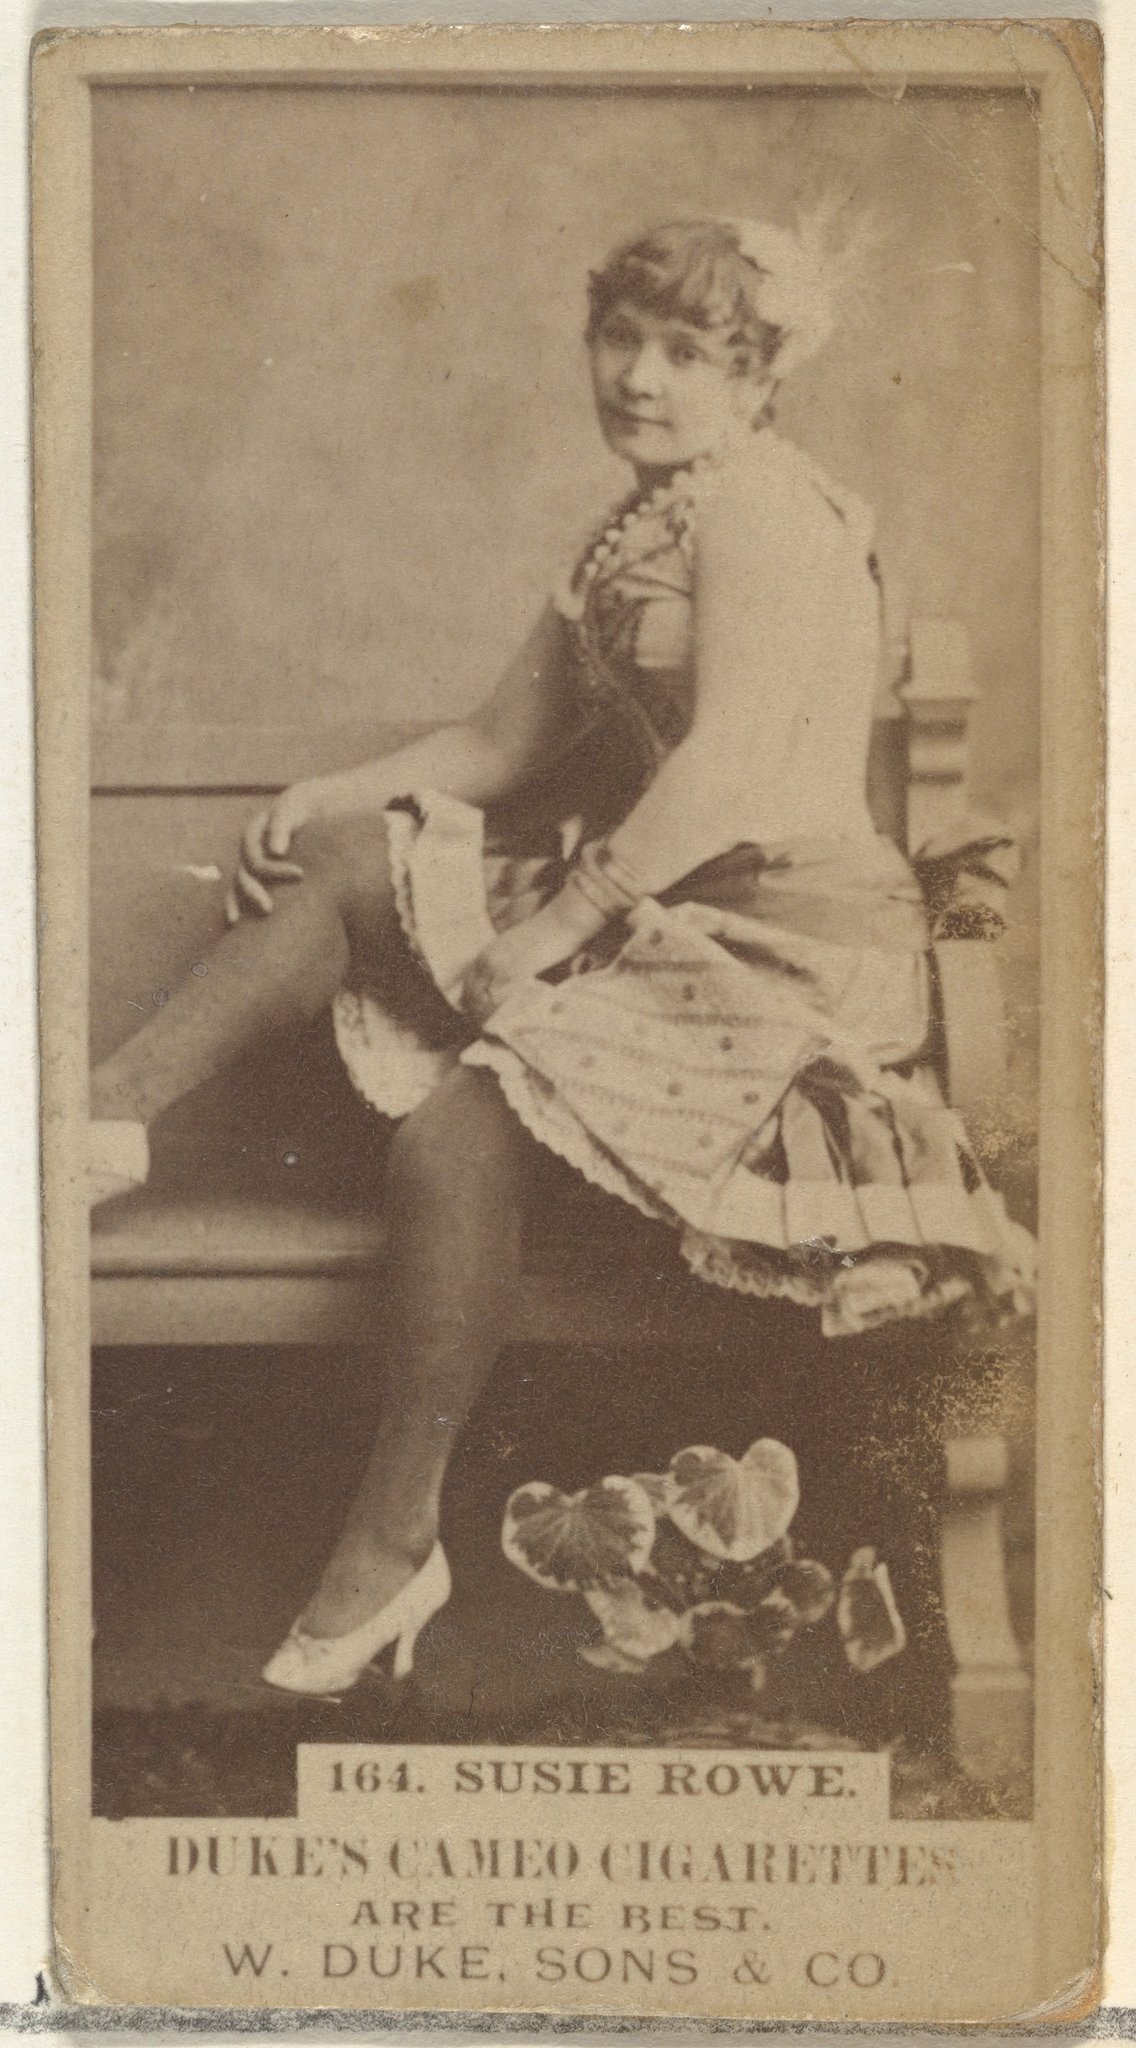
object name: photograph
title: Card Number 164, Susie Rowe, from the Actors and Actresses series (N145-5) issued by Duke Sons & Co. to promote Cameo Cigarettes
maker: w. duke, sons & co.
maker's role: publisher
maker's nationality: american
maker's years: 1870-1920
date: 1880-1889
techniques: albumen silver print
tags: portraits,women,actresses